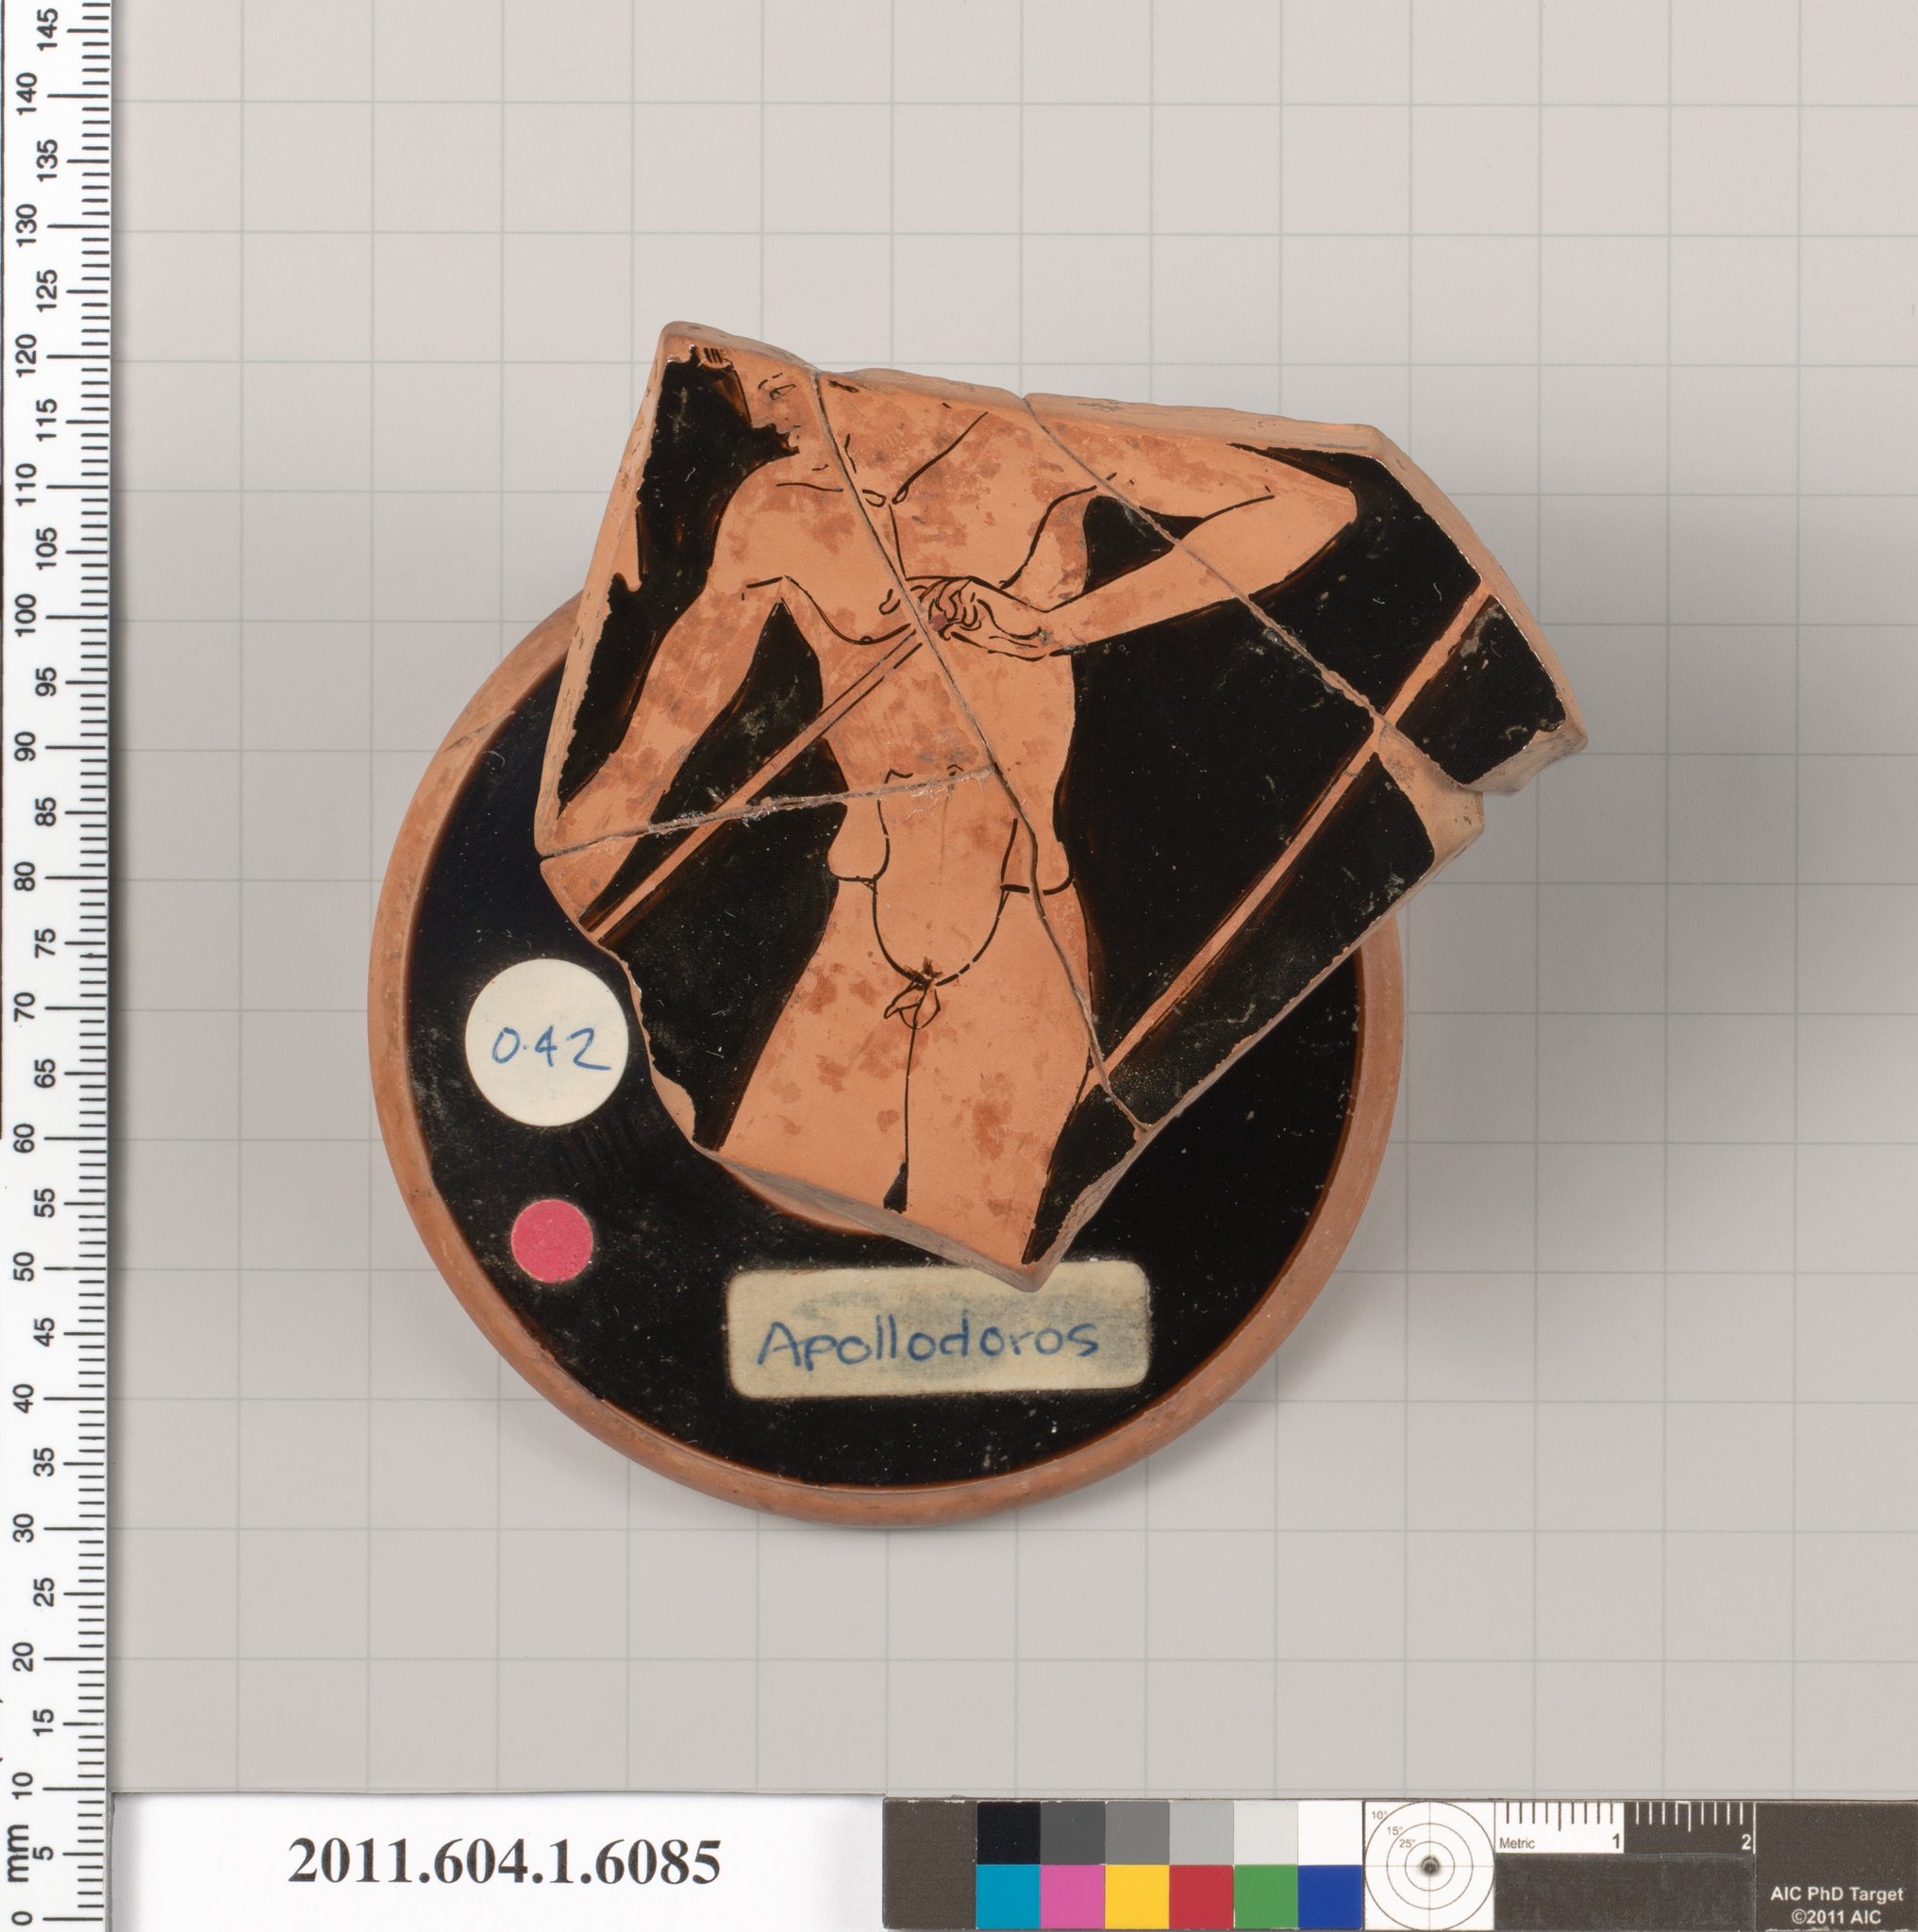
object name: kylix fragment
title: Terracotta fragment of a kylix (drinking cup)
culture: greek, attic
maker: apollodoros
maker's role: artist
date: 500-490 BCE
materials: terracotta